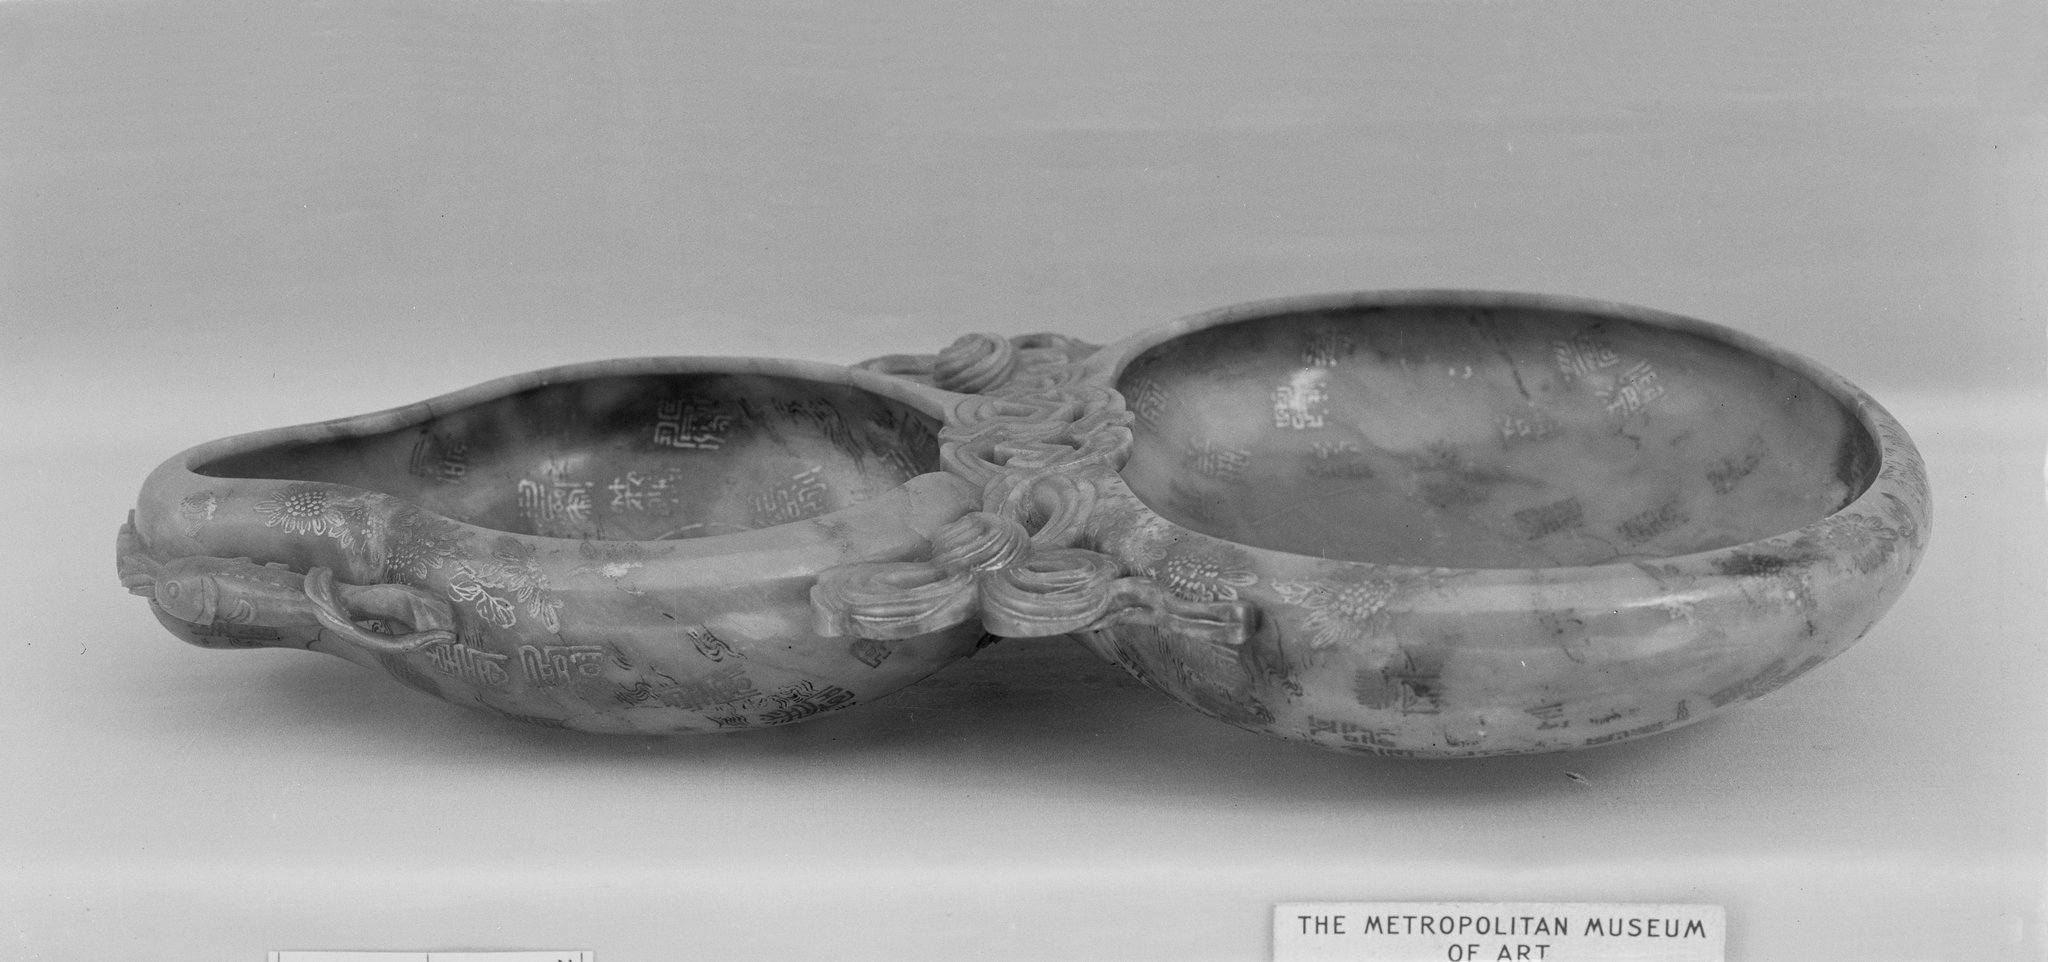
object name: water dish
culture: chinese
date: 1736-1795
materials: jade